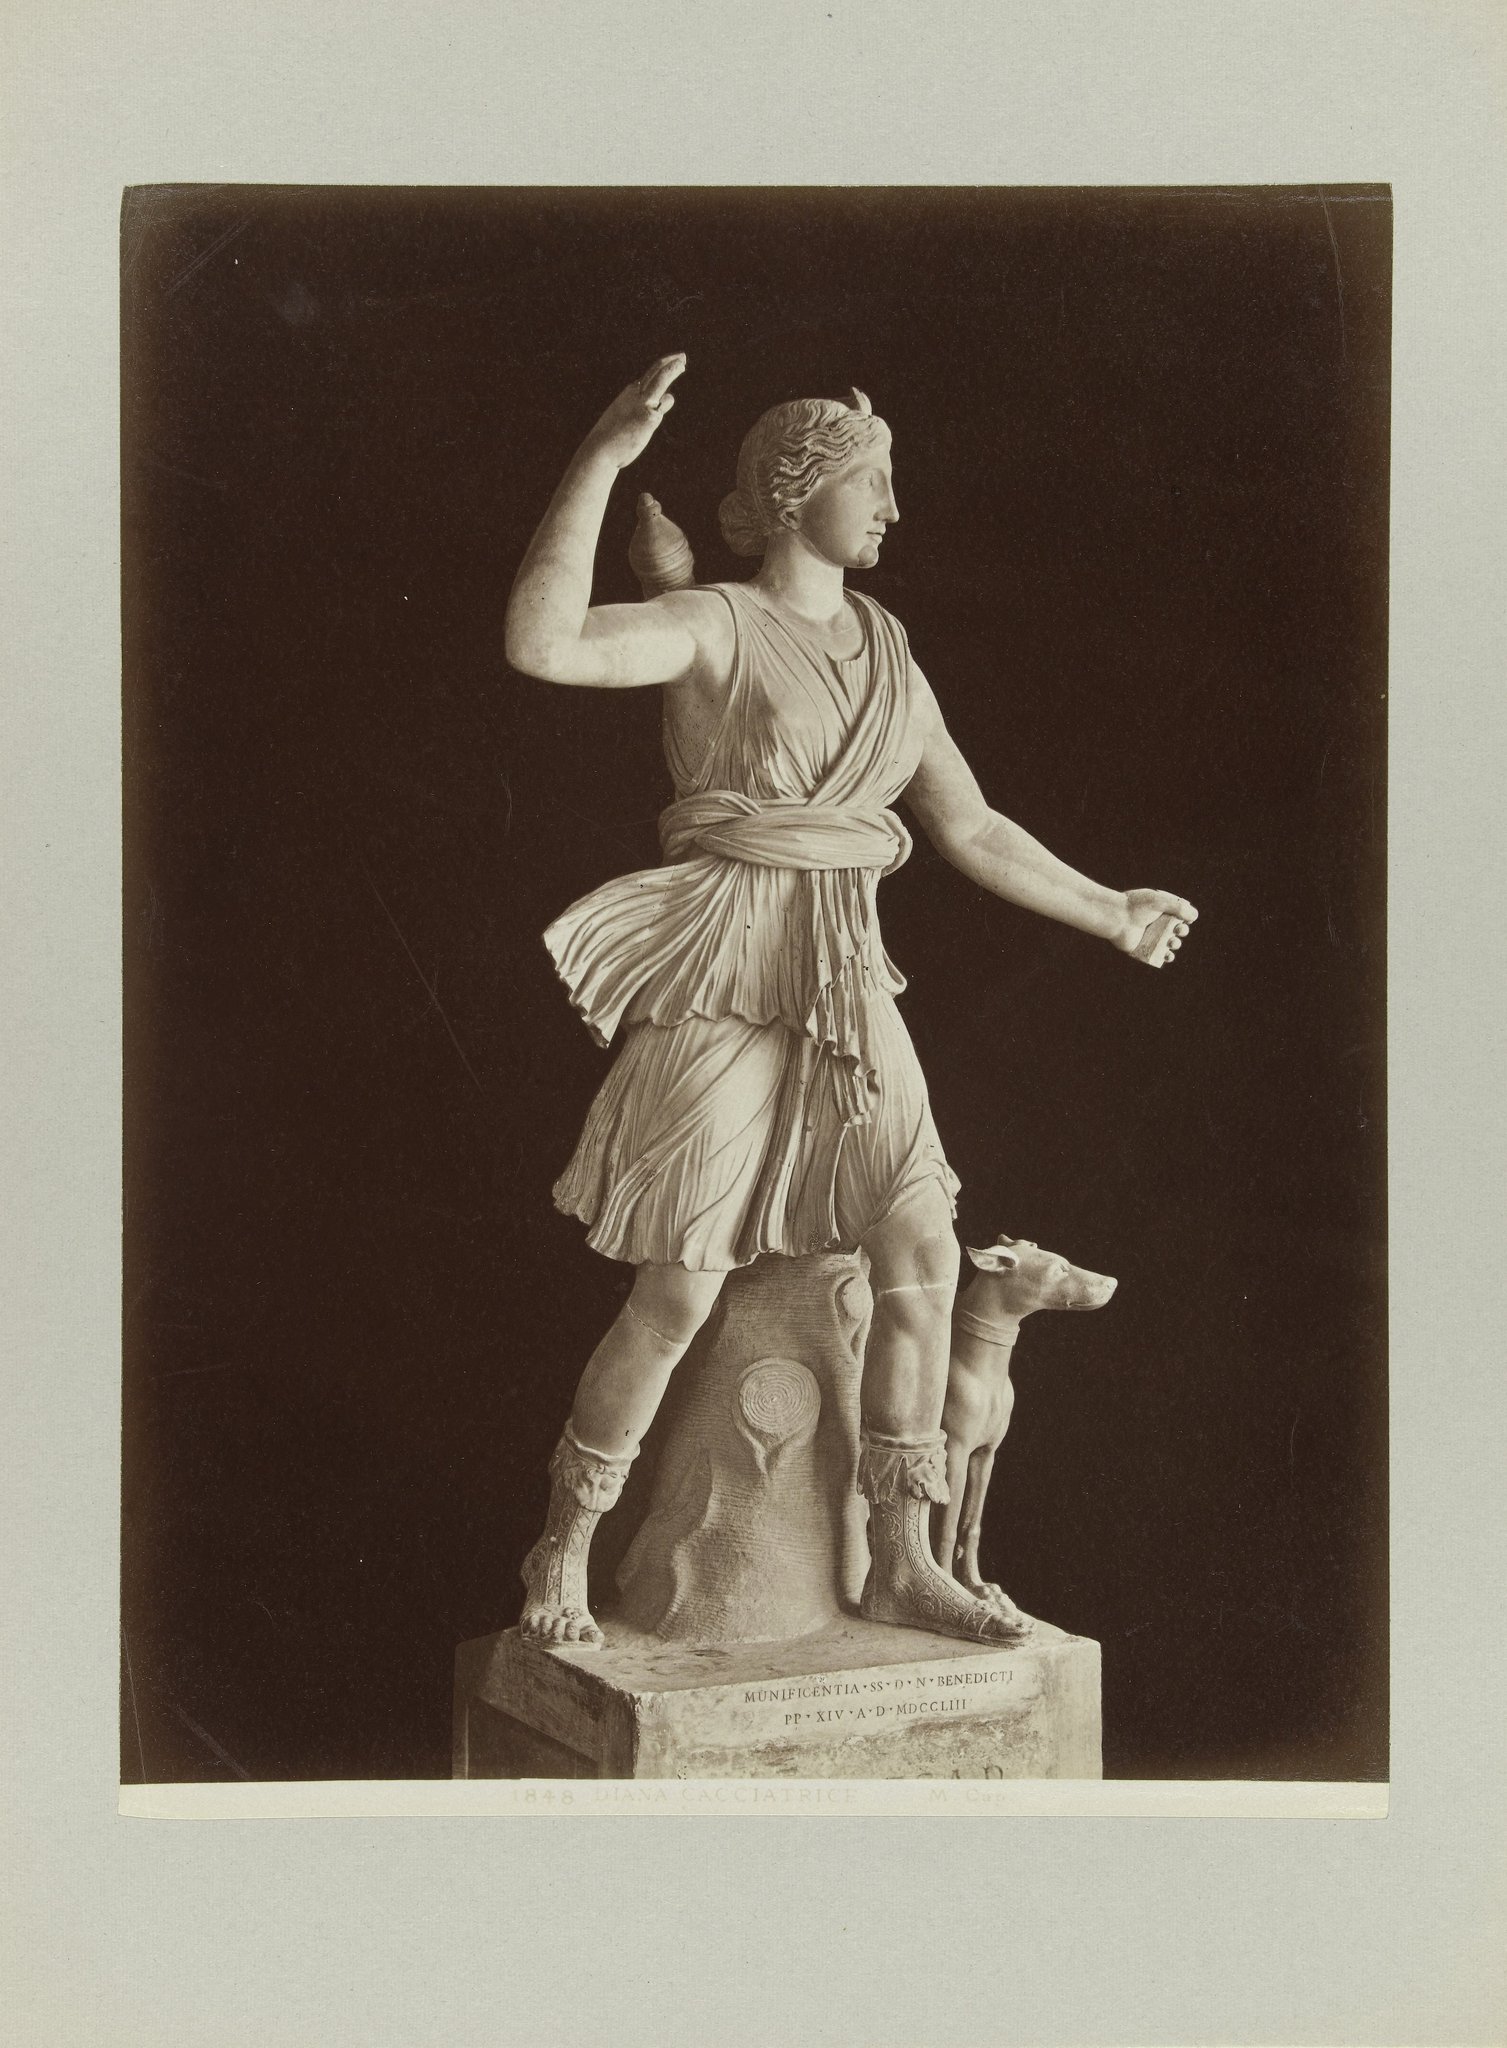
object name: photograph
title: Sculptuur van jagende Diana met hond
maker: Anonymous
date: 1880-1904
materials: cardboard, paper, photographic support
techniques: albumen print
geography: rome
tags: rome